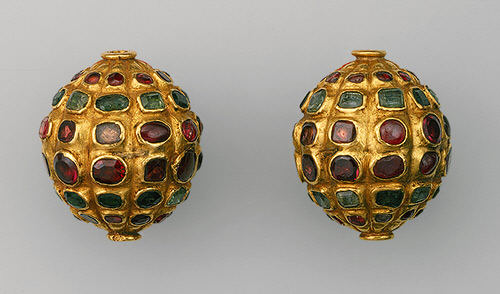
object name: bead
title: Bead, One of a Pair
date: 1701-1800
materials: gemstone, garnet, gold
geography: morocco